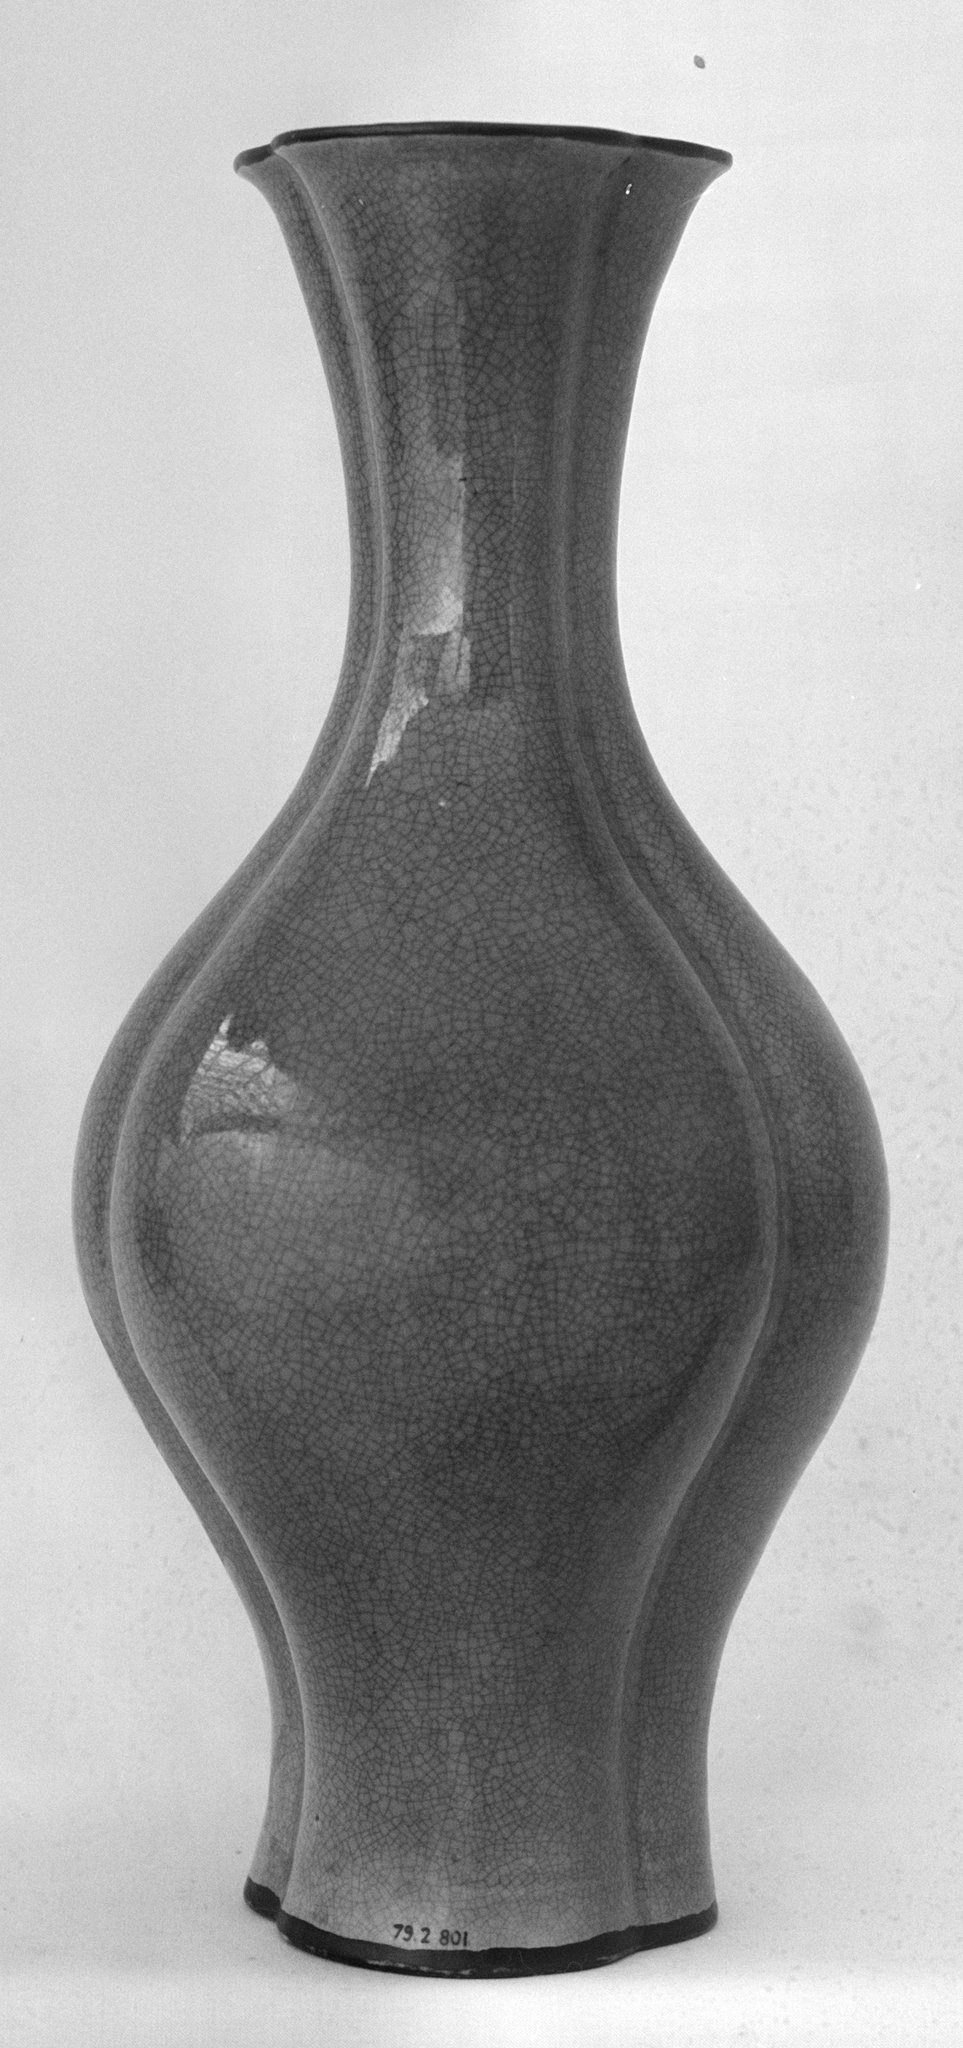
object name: vase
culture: chinese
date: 1767-1833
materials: enamel, porcelain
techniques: overglaze, painting, polychrome